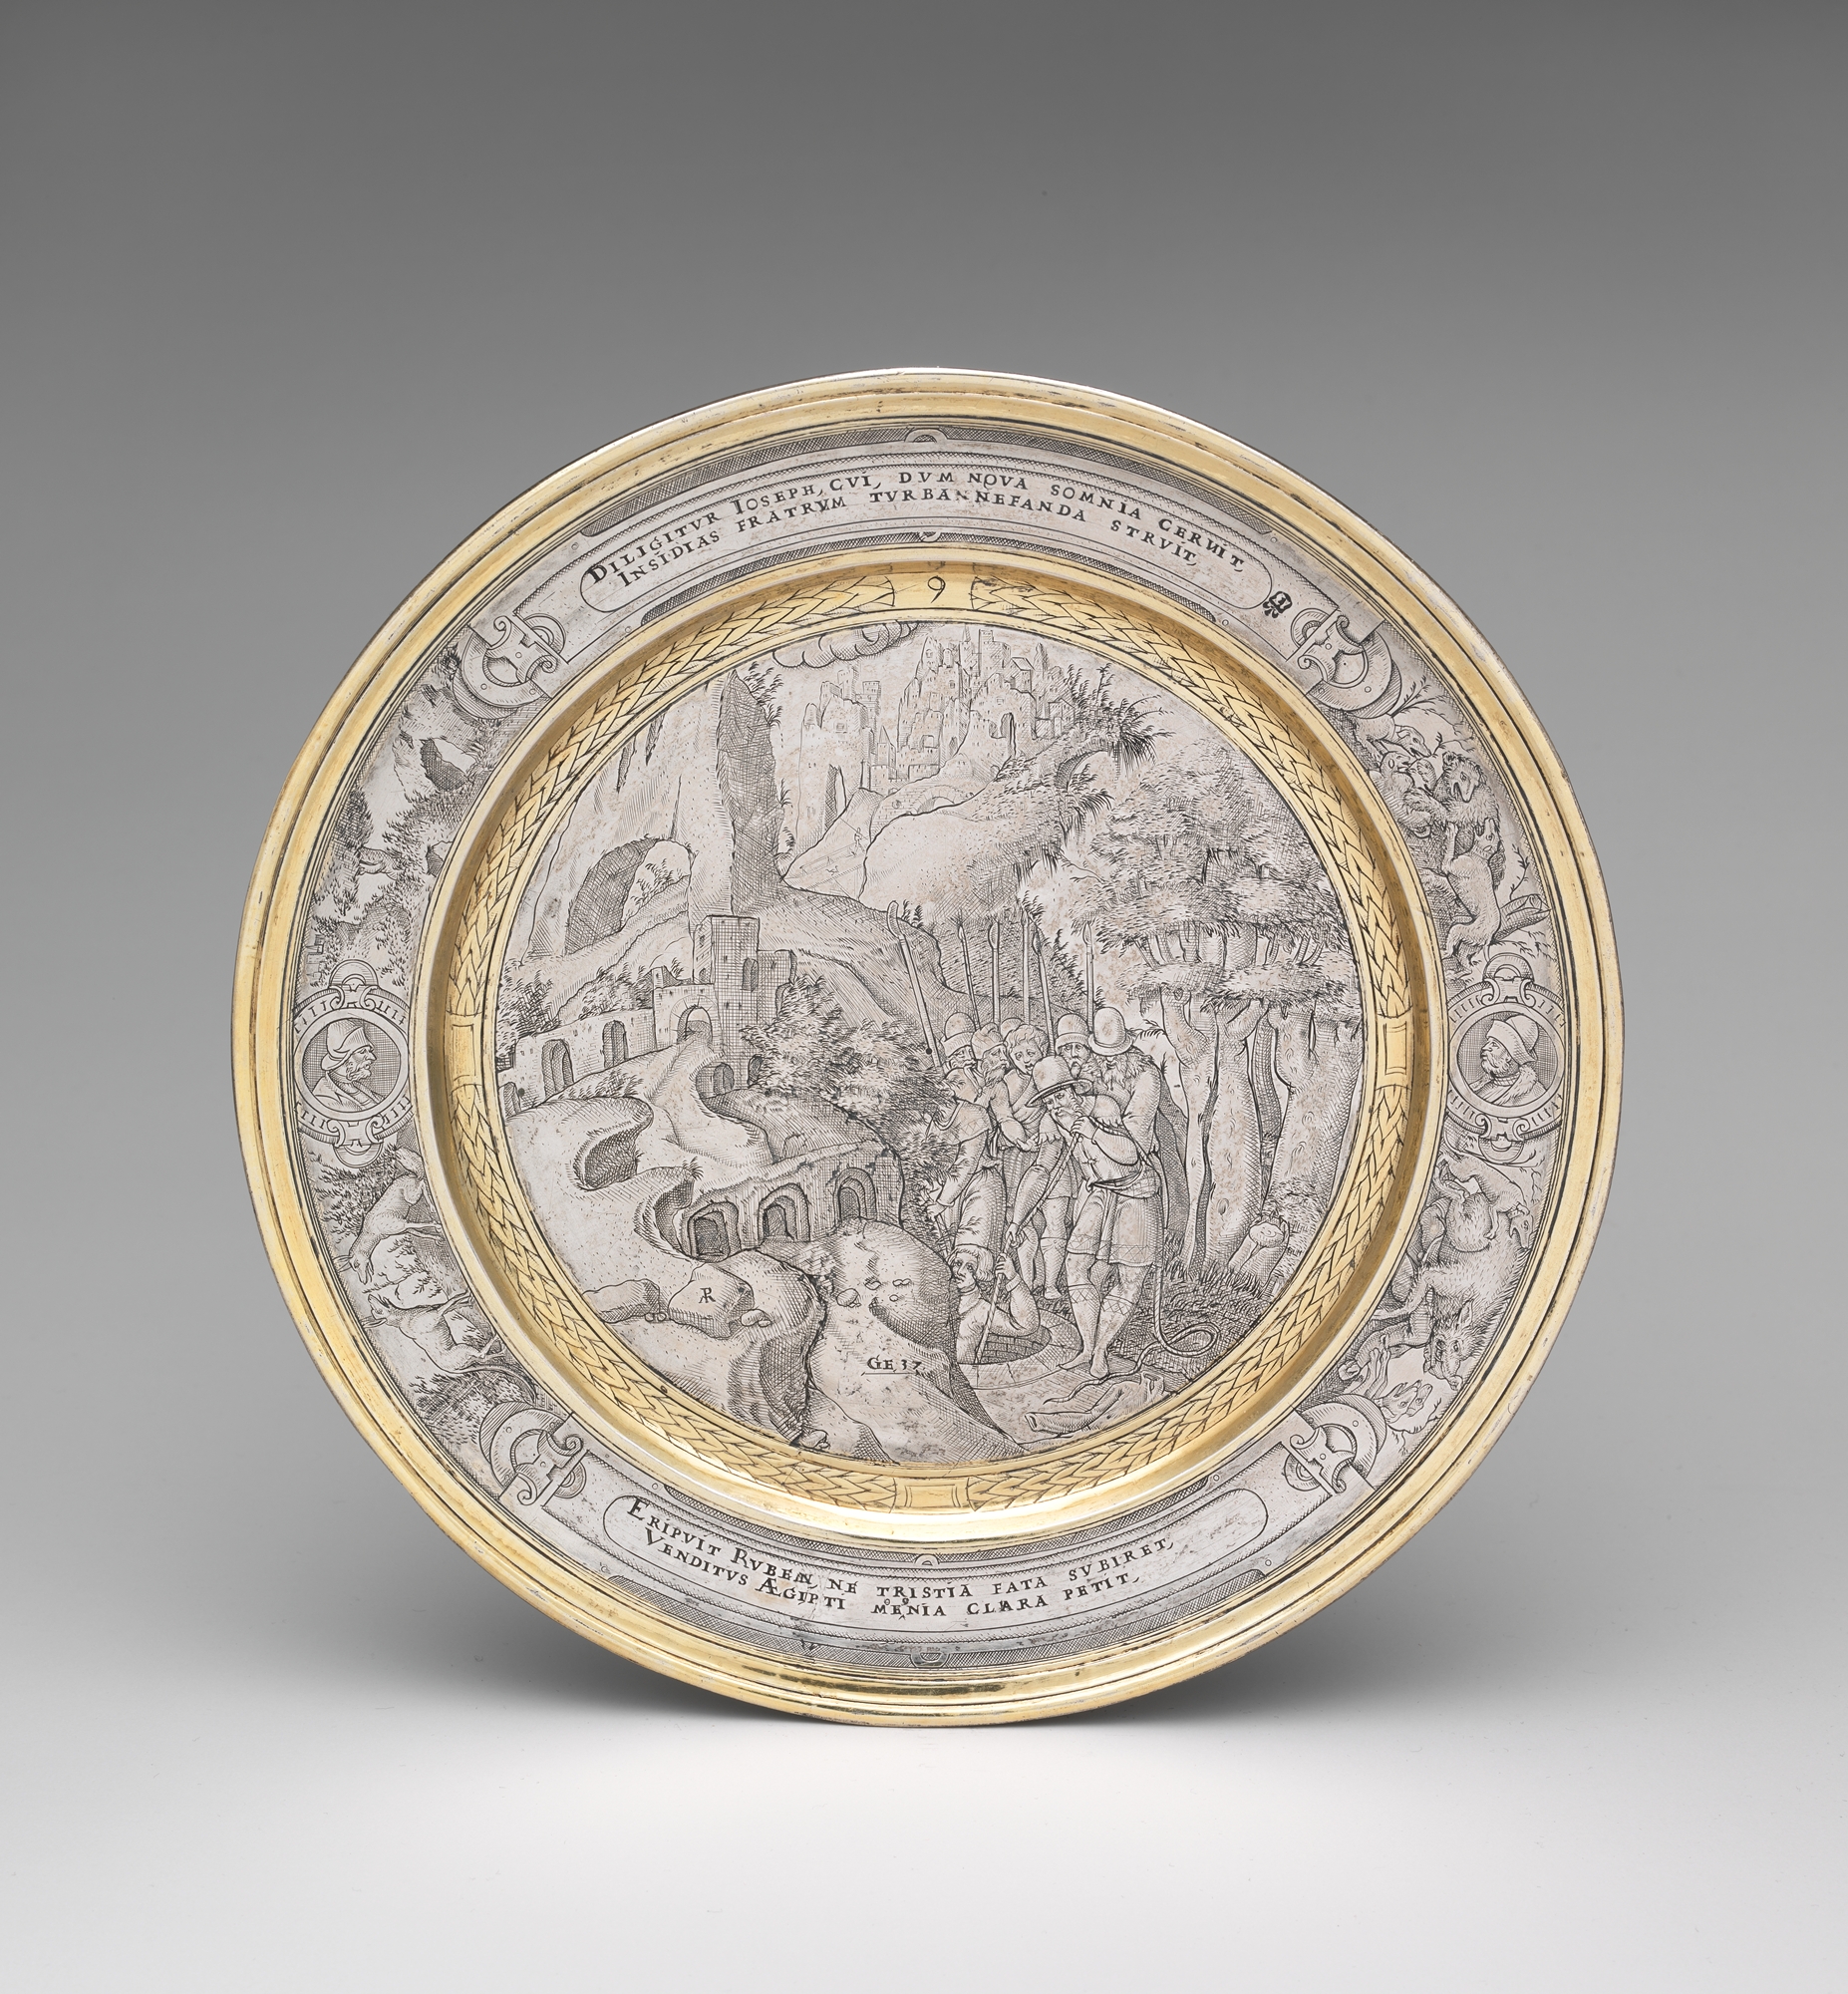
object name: plate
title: Joseph Lowered into the Pit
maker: p.m.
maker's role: engraver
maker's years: 1500-1600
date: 1567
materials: silver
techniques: gilding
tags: men,women,rabbits,landscapes